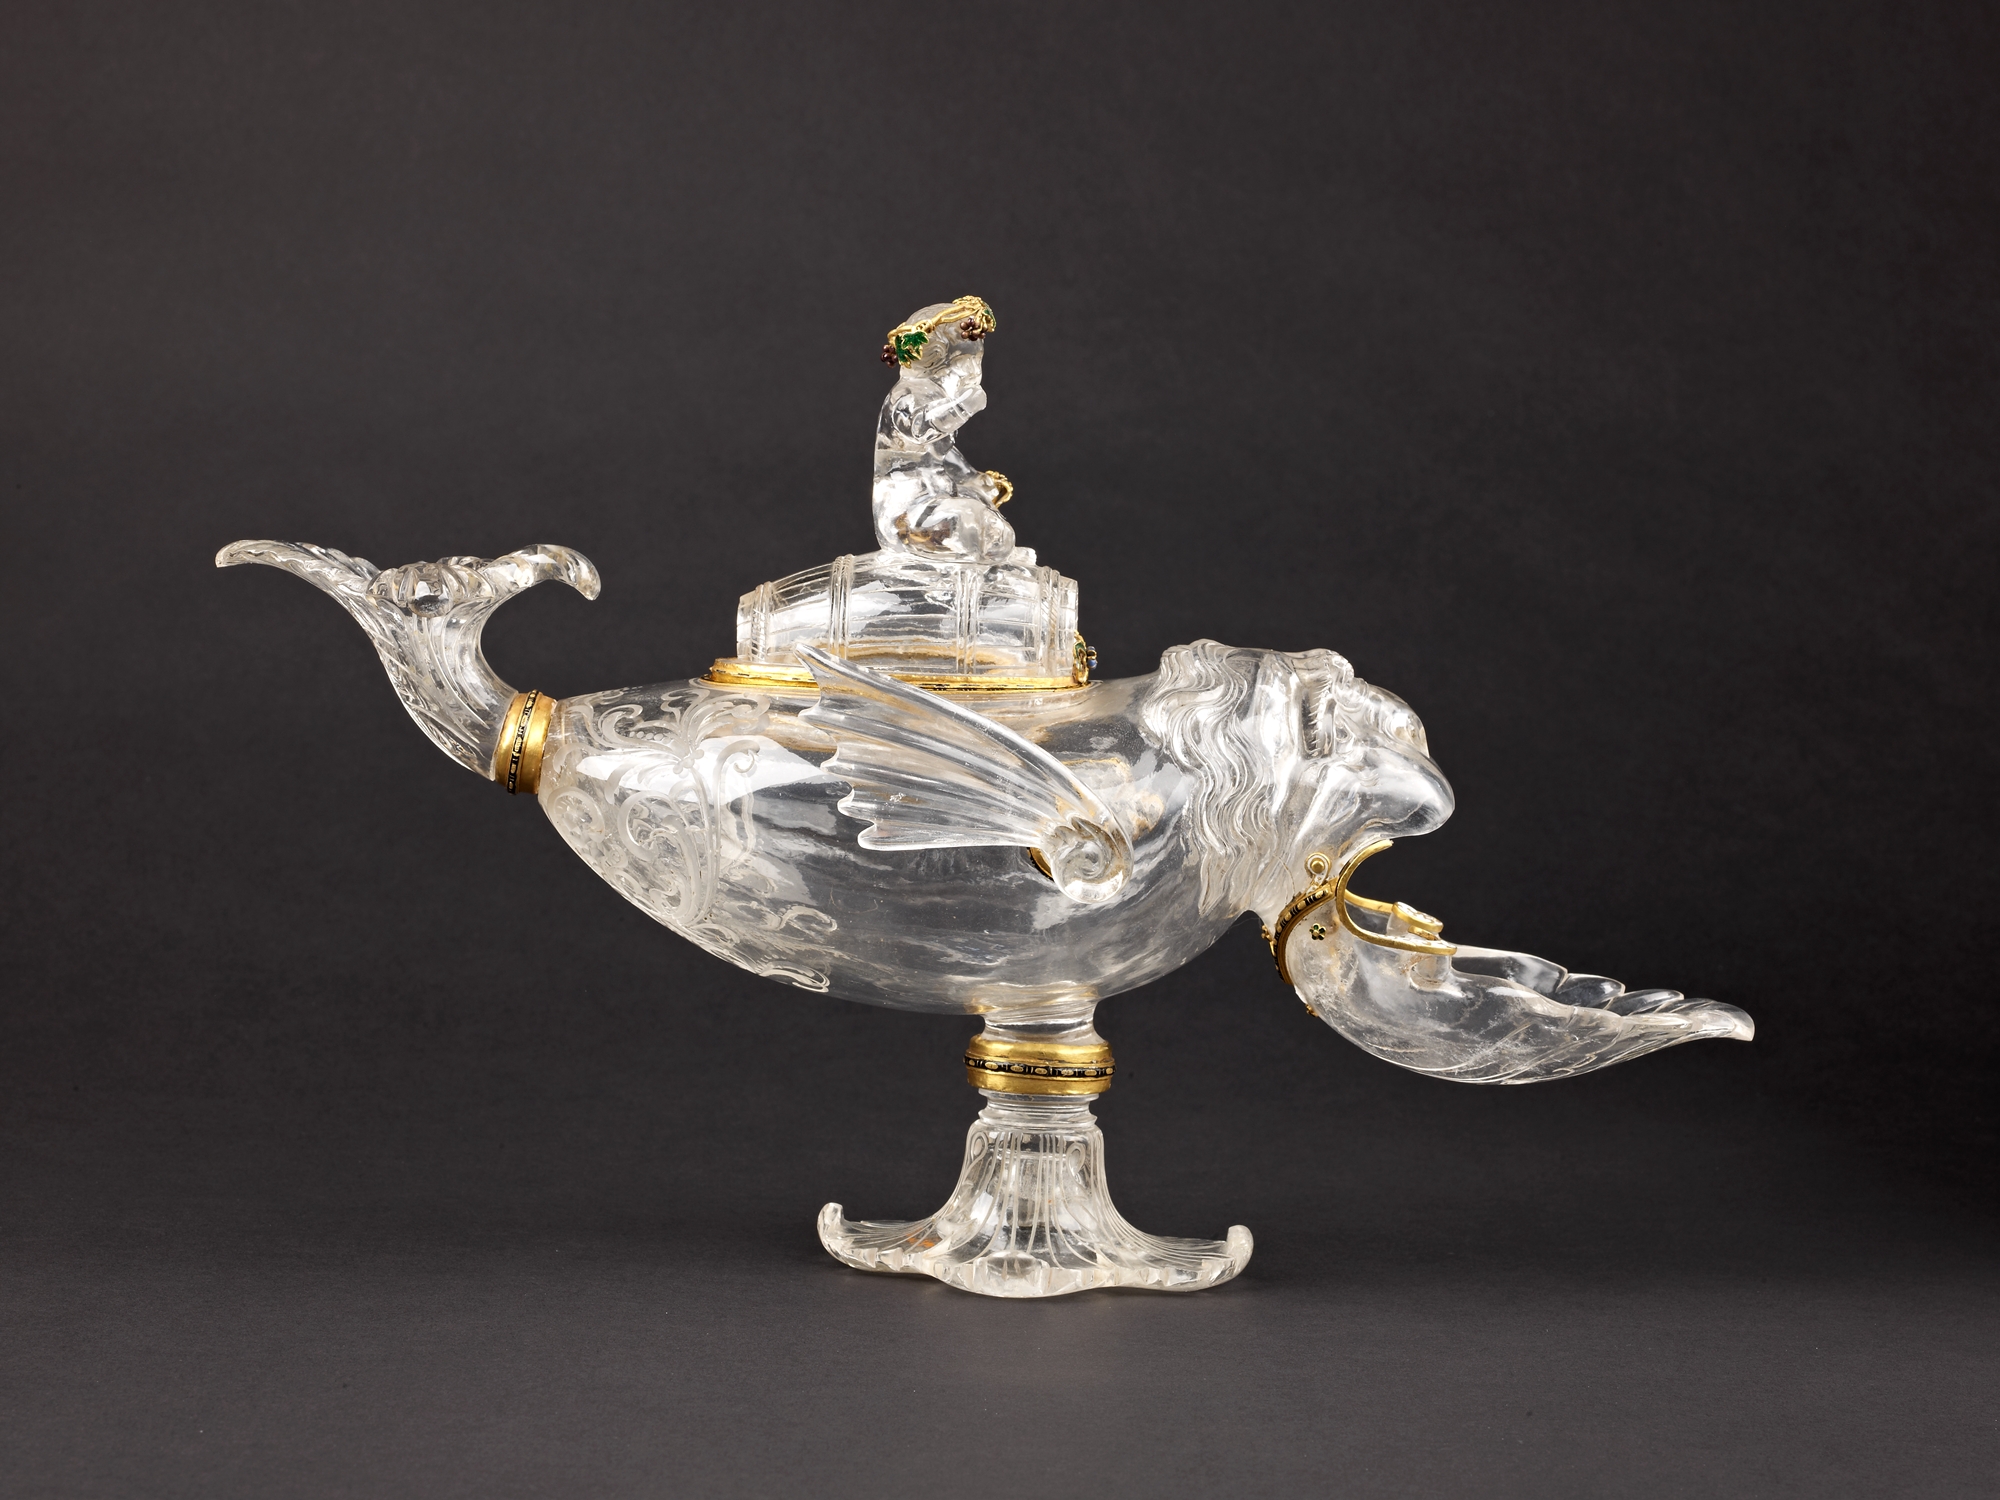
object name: cup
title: "Ewer" in the Form of a Sea Monster Ridden by Bacchus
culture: german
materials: gold, quartz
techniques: cutting, enamel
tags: monsters,bacchus